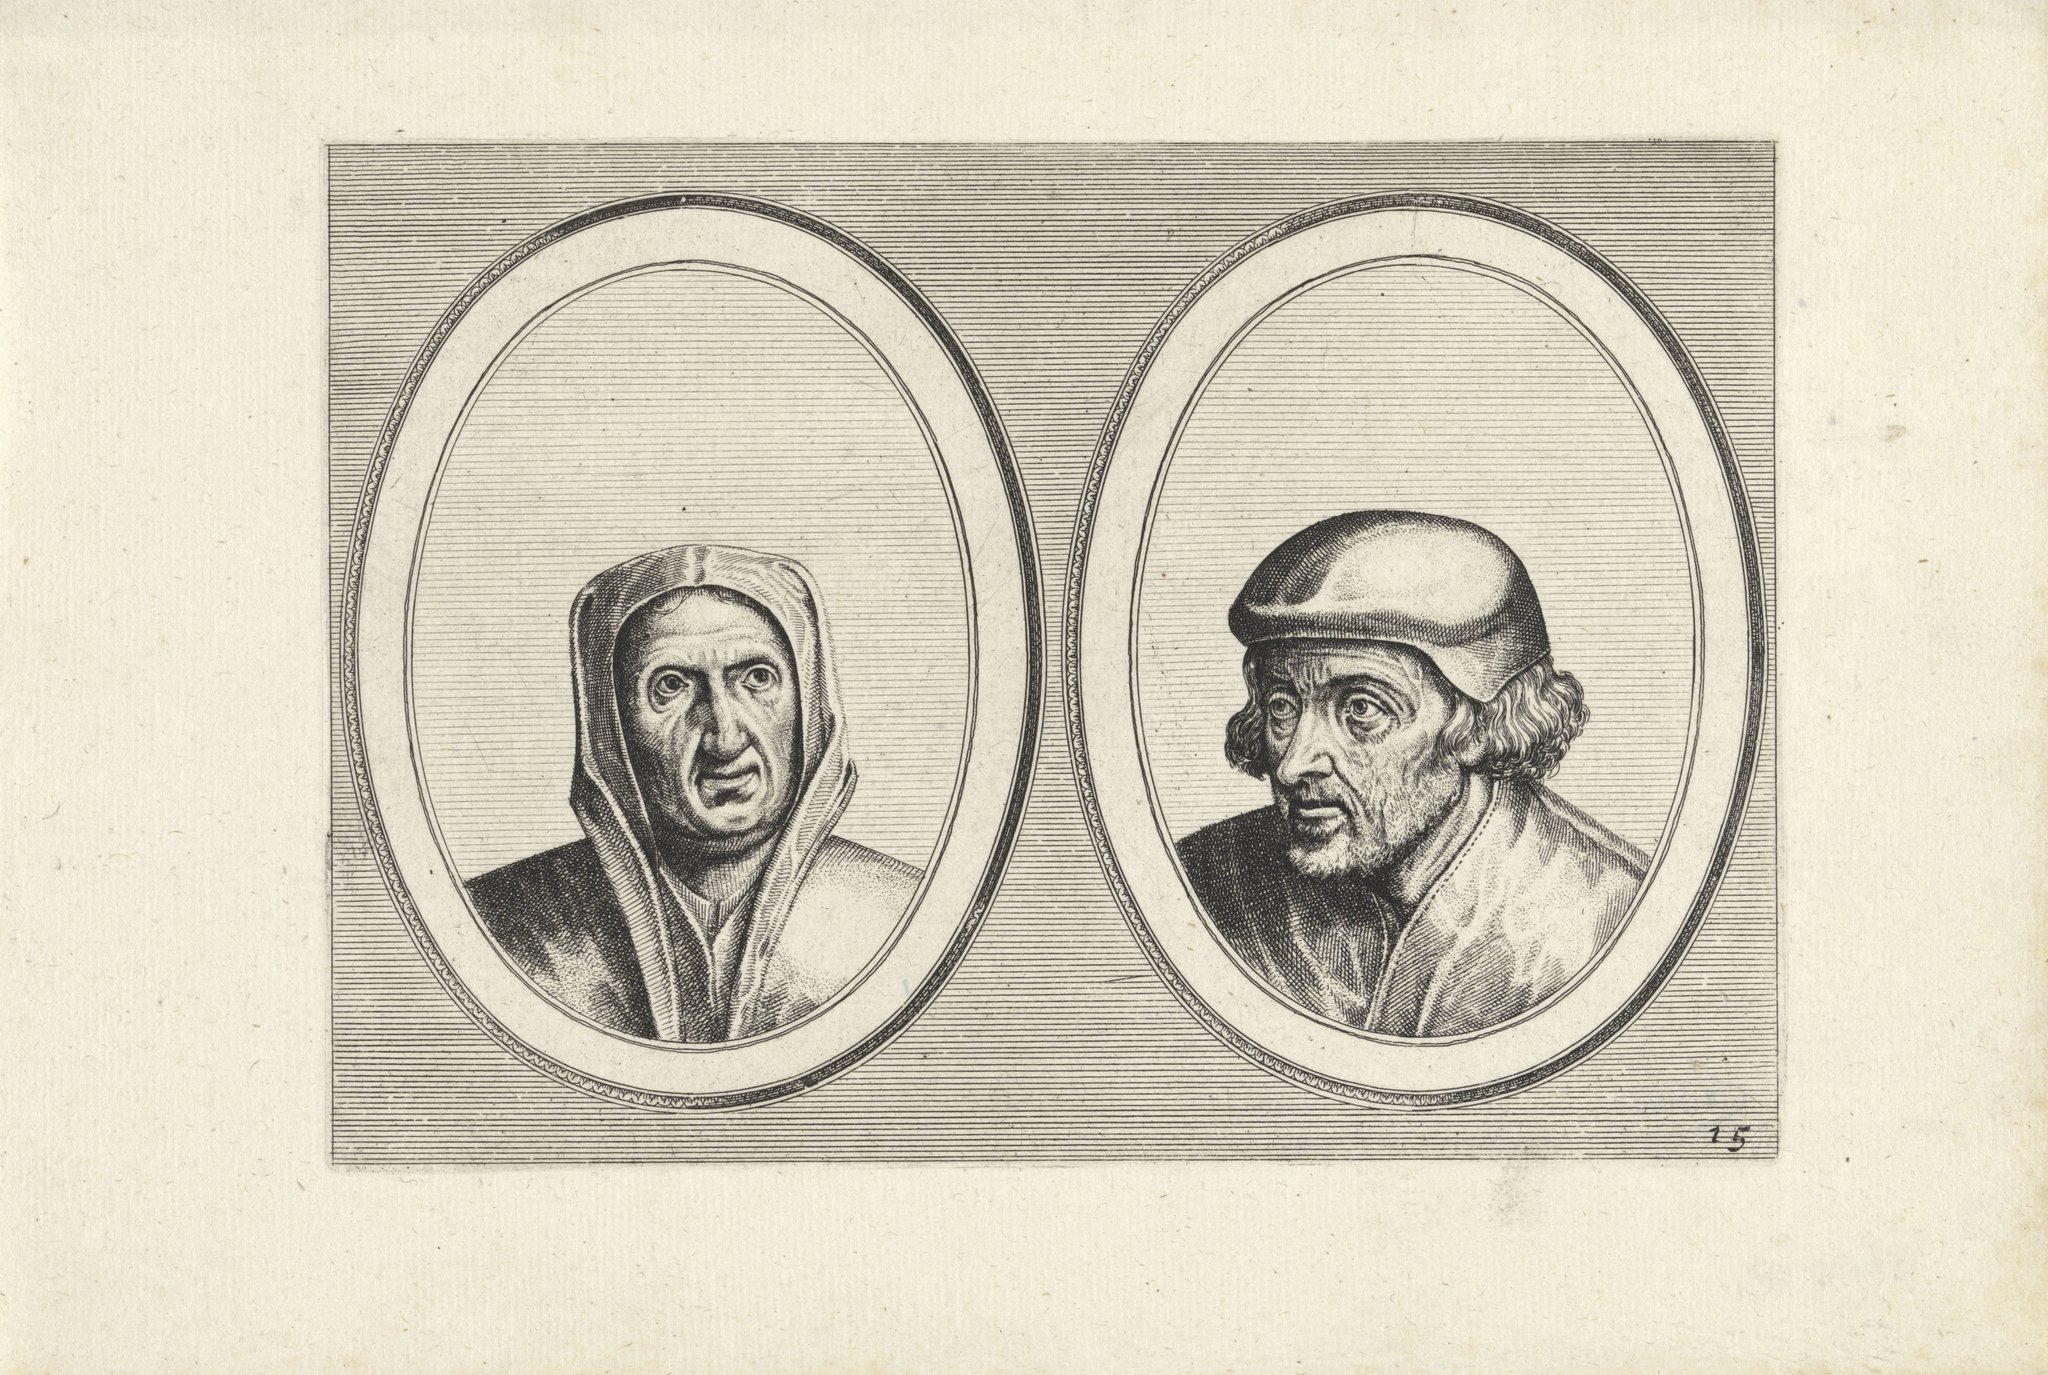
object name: print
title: Beveynsde Hil en Listighe Jorden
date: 1612-1652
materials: paper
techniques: engraving, etching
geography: amsterdam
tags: head-gear, farmers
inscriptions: collector's mark: Lugt 2228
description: Prent uit een serie van 36 prenten met koppen van boeren en boerinnen.